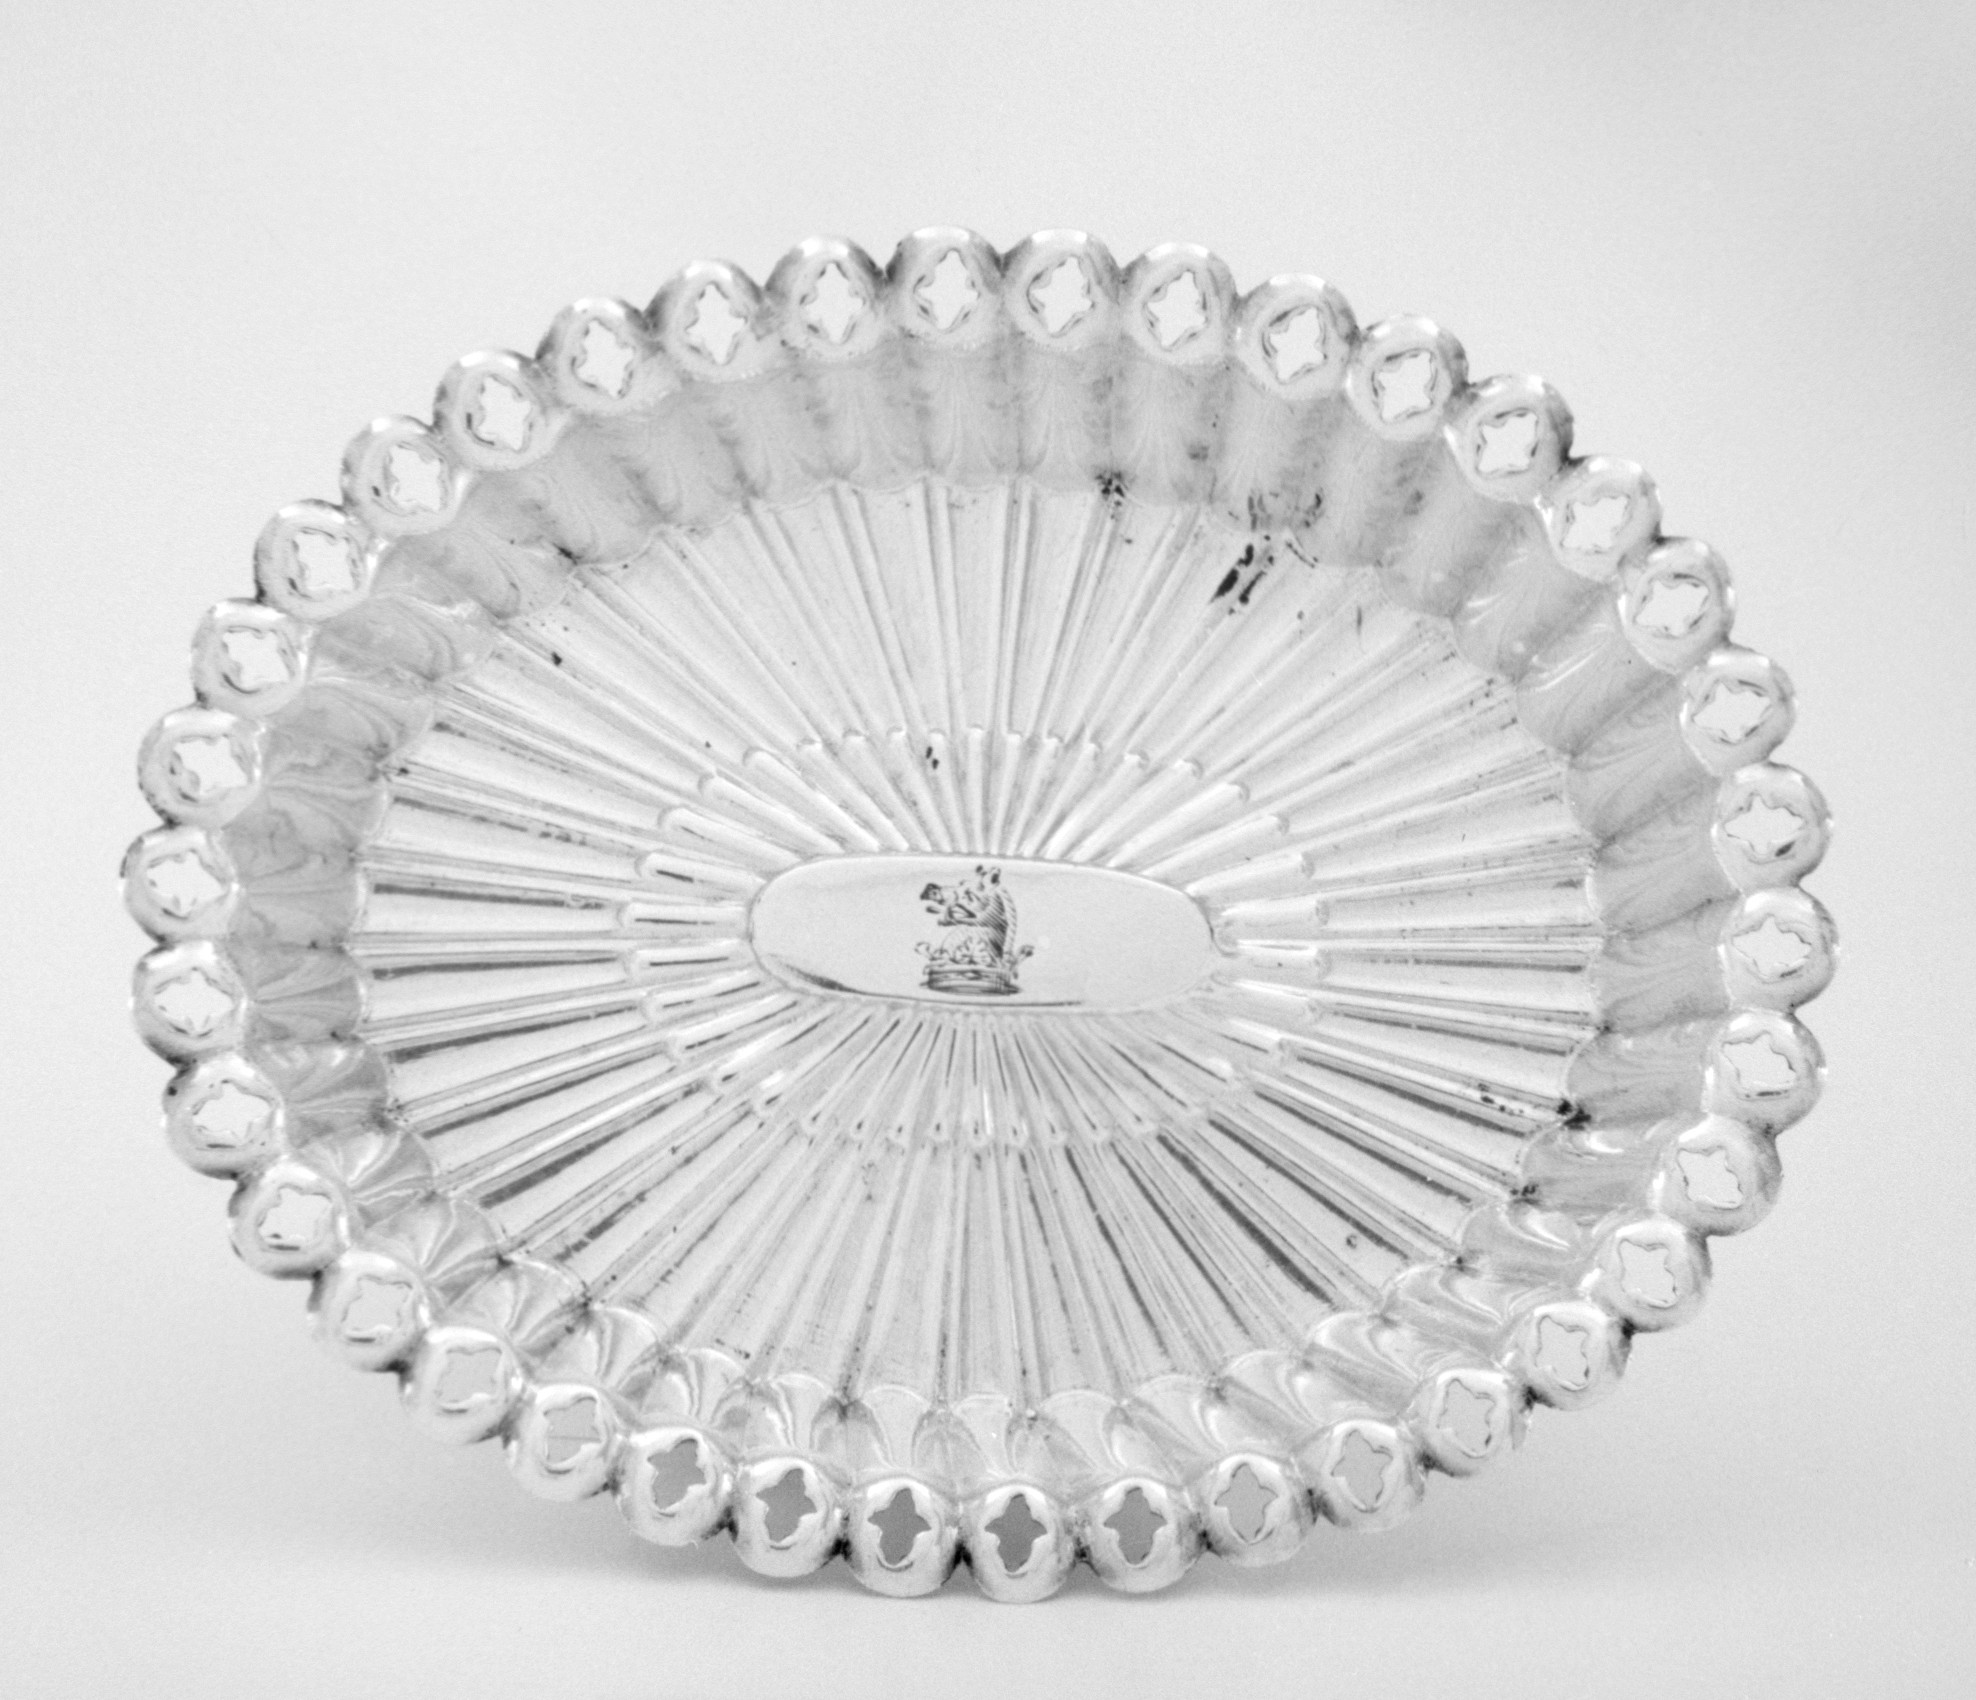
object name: sweetmeat dish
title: Set of four sweetmeat dishes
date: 1760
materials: metal